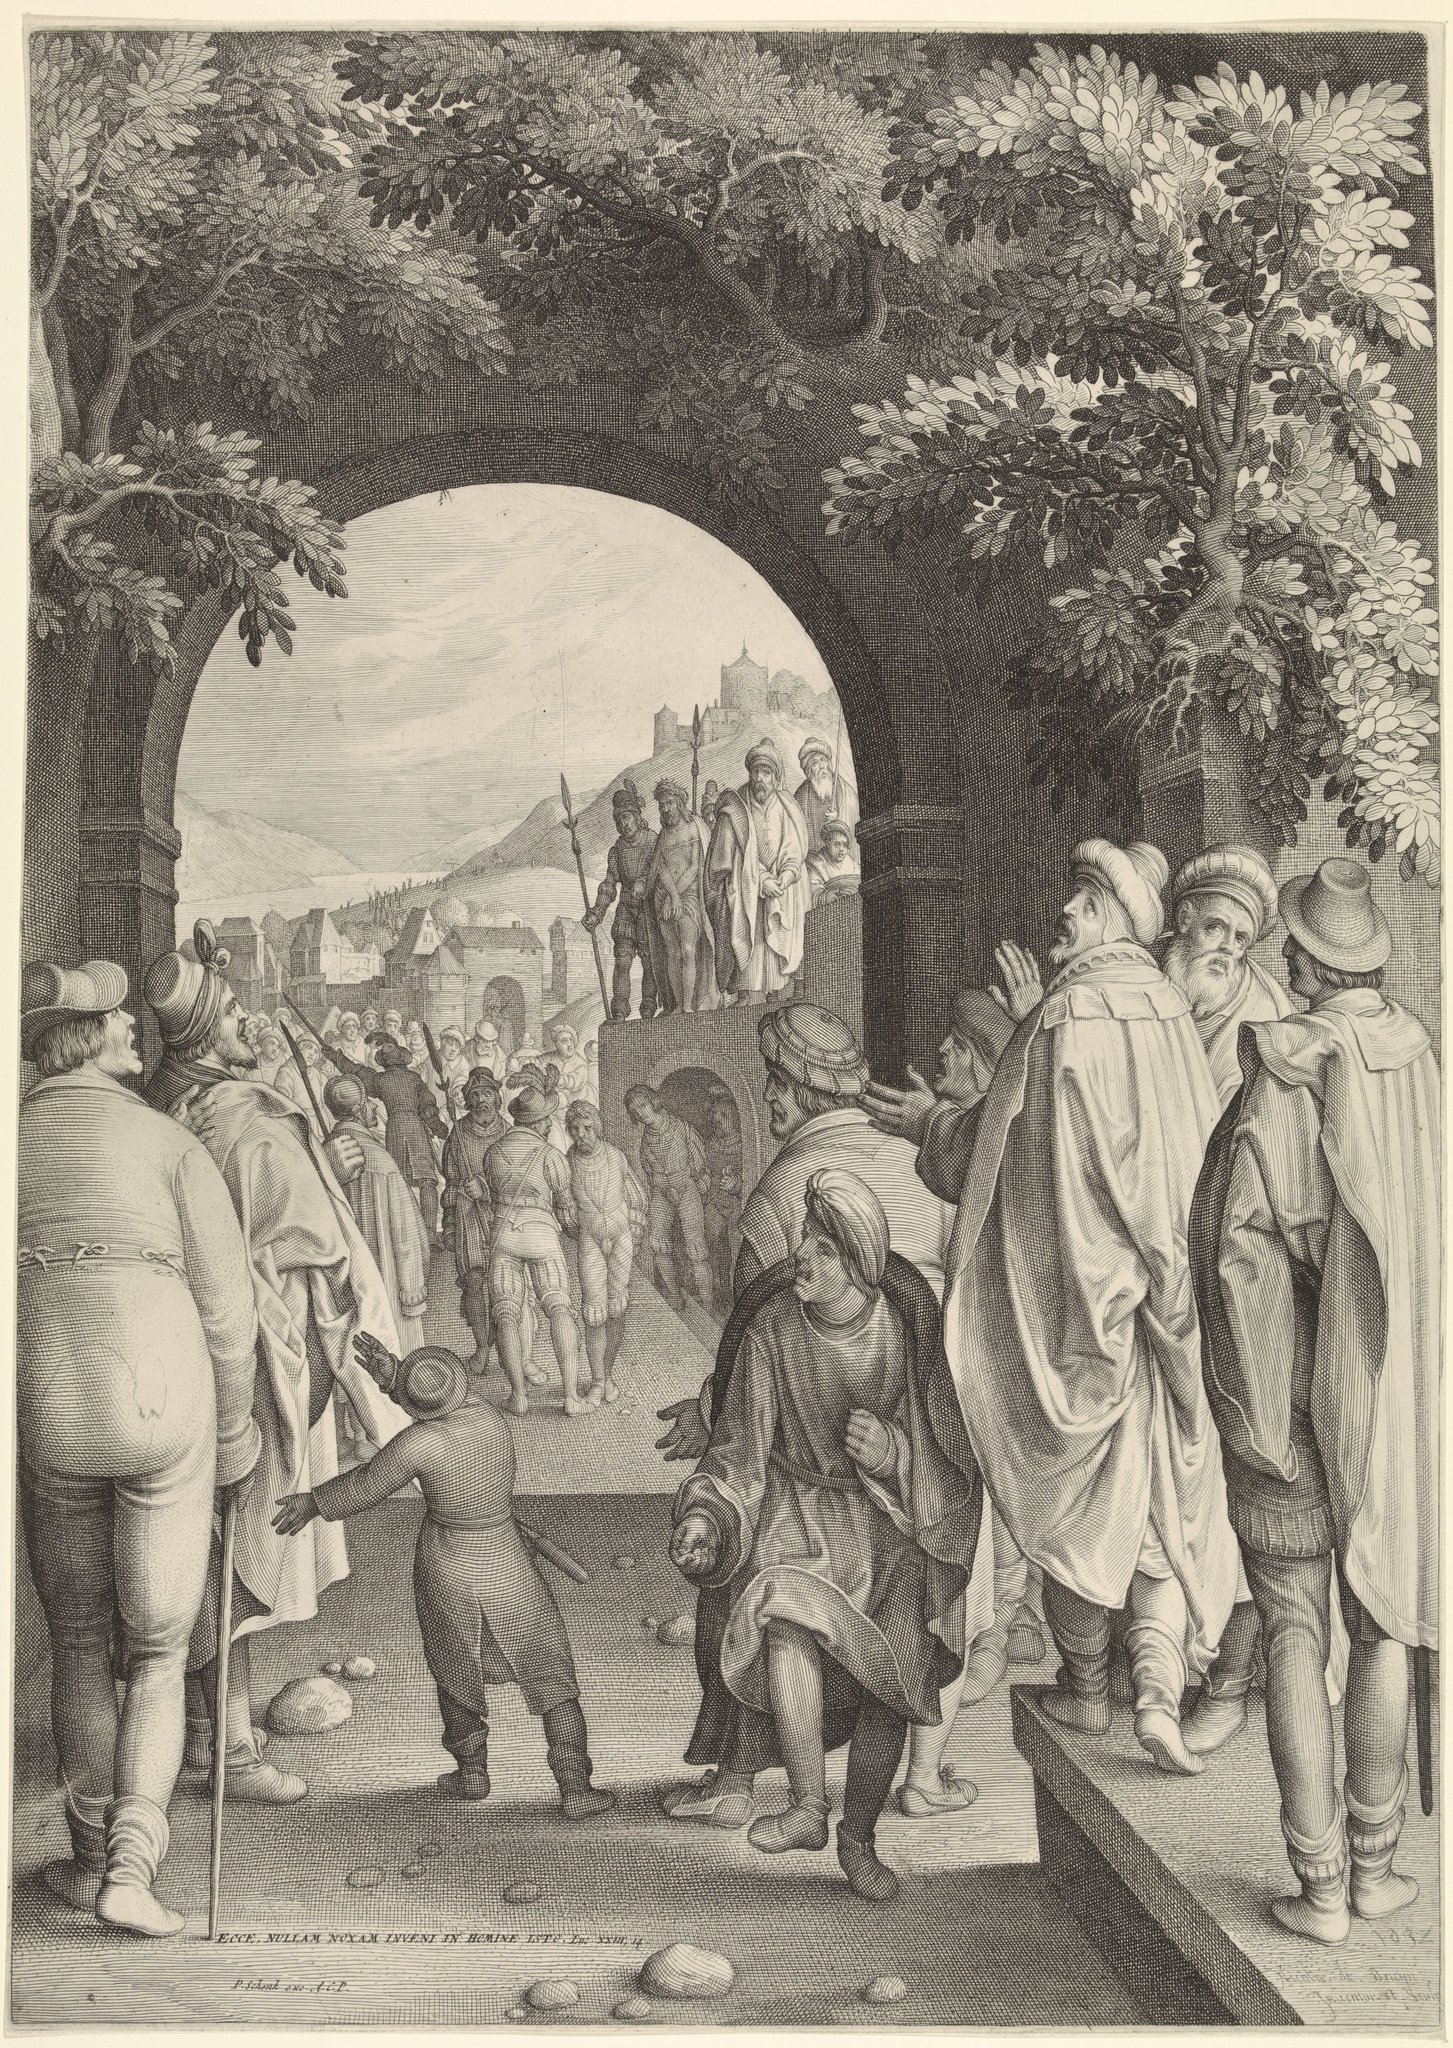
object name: print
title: Ecce Homo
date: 1632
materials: paper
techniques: engraving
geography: rotterdam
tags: choice between christ and barabbas, pilate showing christ to the people, 'ostentatio christi', 'ecce homo' (john 19:4-6)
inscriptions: date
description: Op een terras toont Pontius Pilatus de gegeselde Christus aan het Joodse volk. Onder het verhoog brengt een soldaat Barabbas naar buiten. Pilatus vraagt de menigte wie moet worden vrijgelaten: Barabbas of Christus.